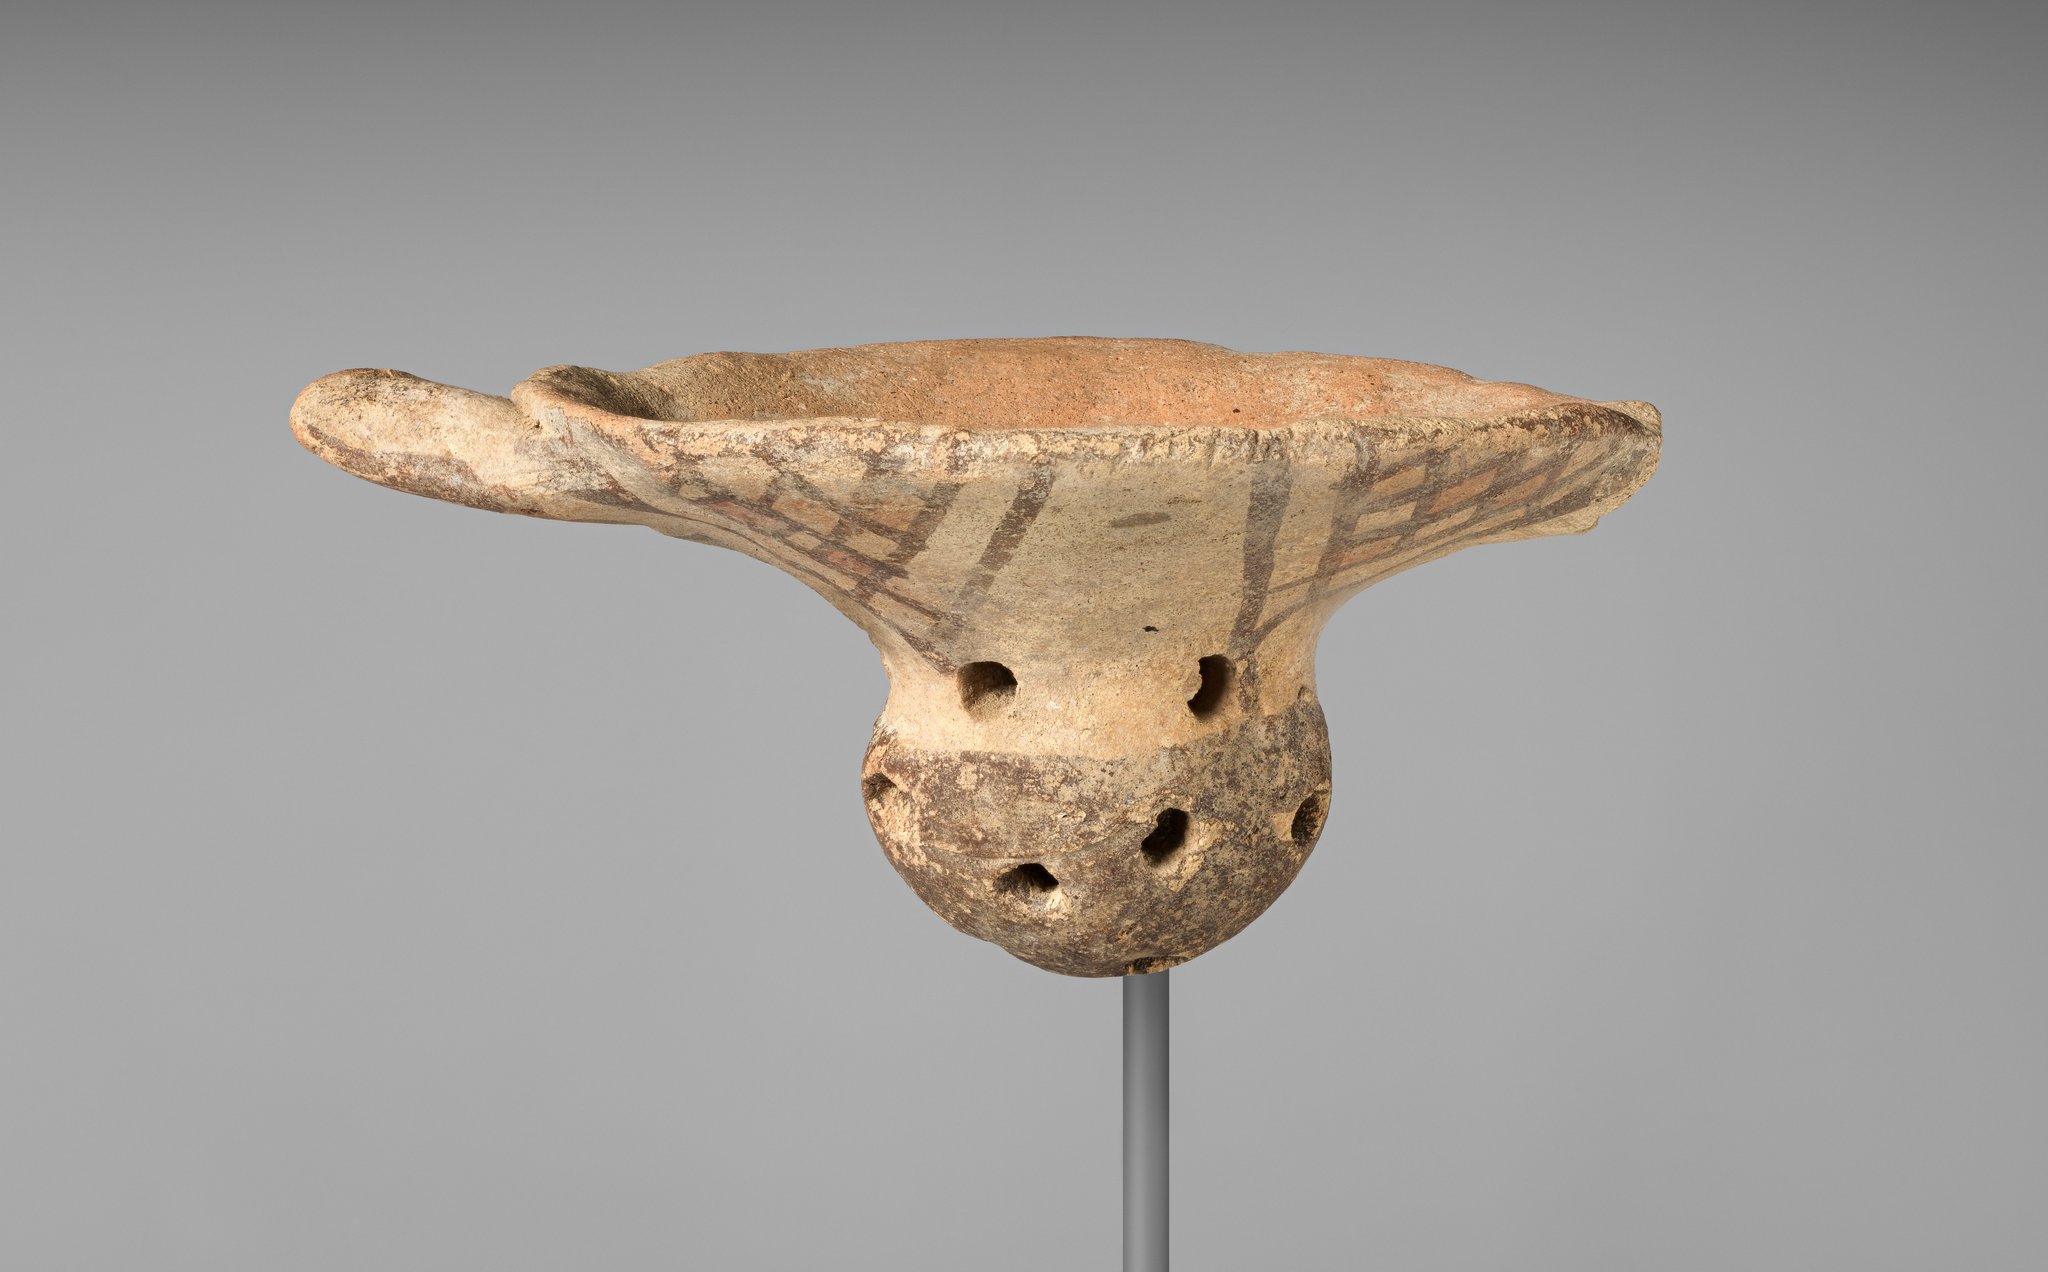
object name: strainer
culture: cypriot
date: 1125-1050 BCE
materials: terracotta